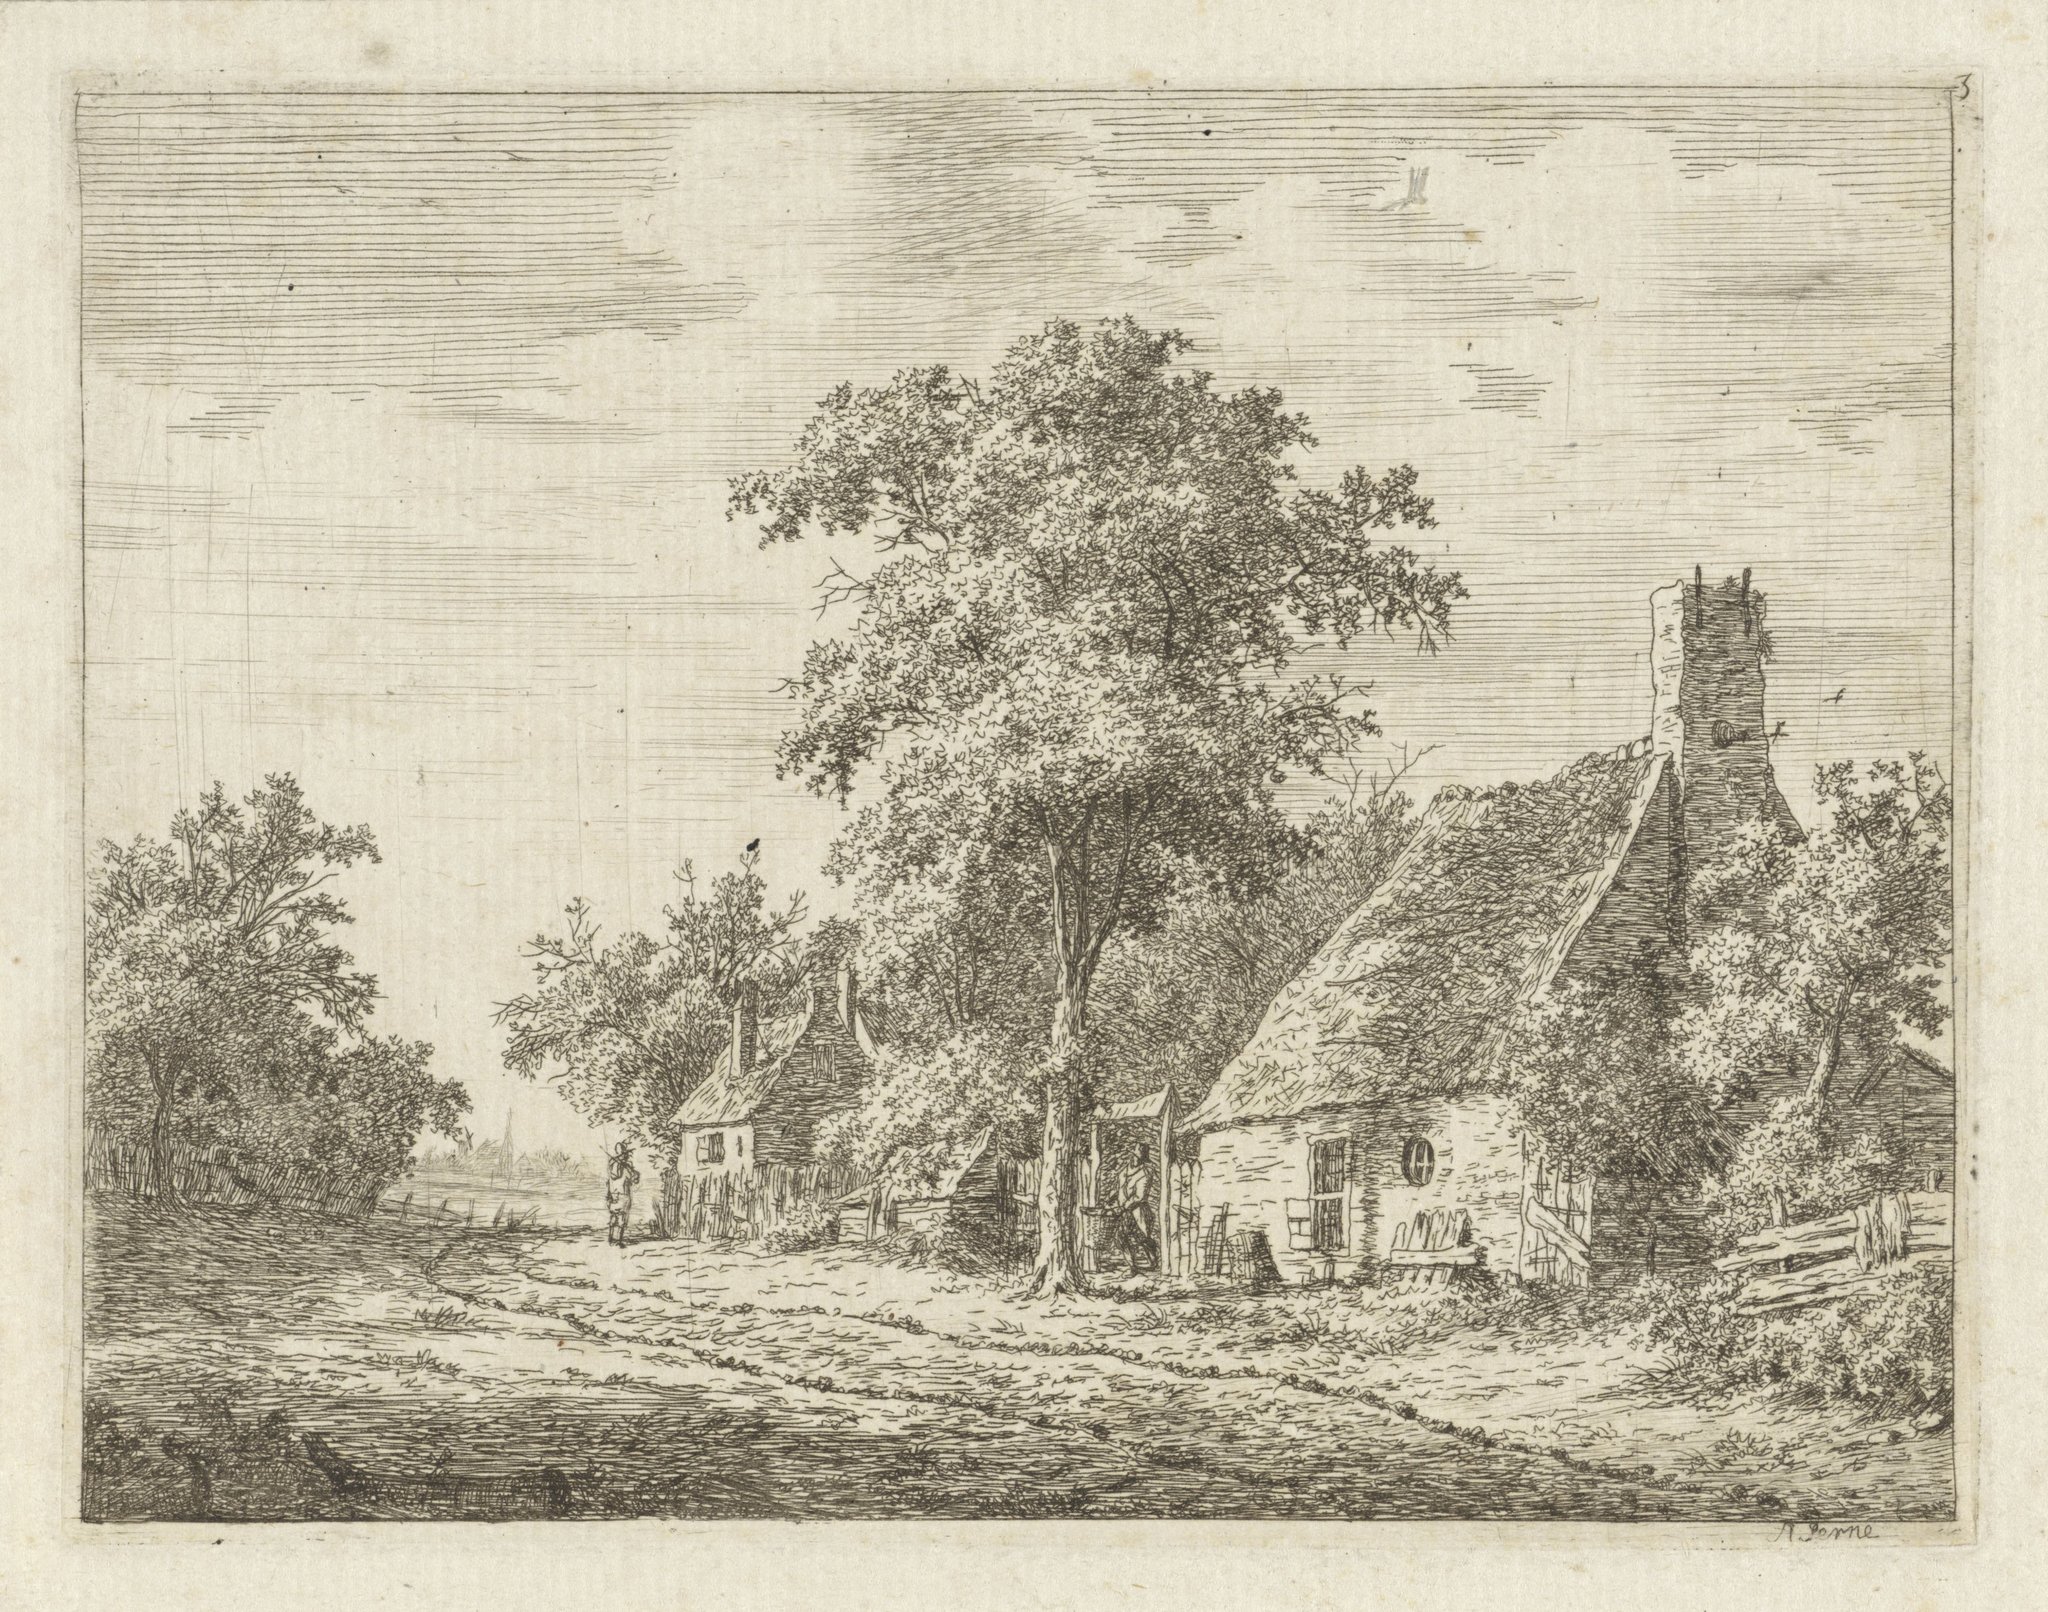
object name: print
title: Twee woningen langs een weg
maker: adrianus serné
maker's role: print maker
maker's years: 1773-1853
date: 1783-1853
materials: paper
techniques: etching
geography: netherlands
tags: farm or solitary house in landscape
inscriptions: collector's mark: Lugt 2228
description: Gezicht op een weg waaraan twee woningen liggen. Een man met een mand in de handen verlaat een tuinpoort. Rechtsboven genummerd: 3.